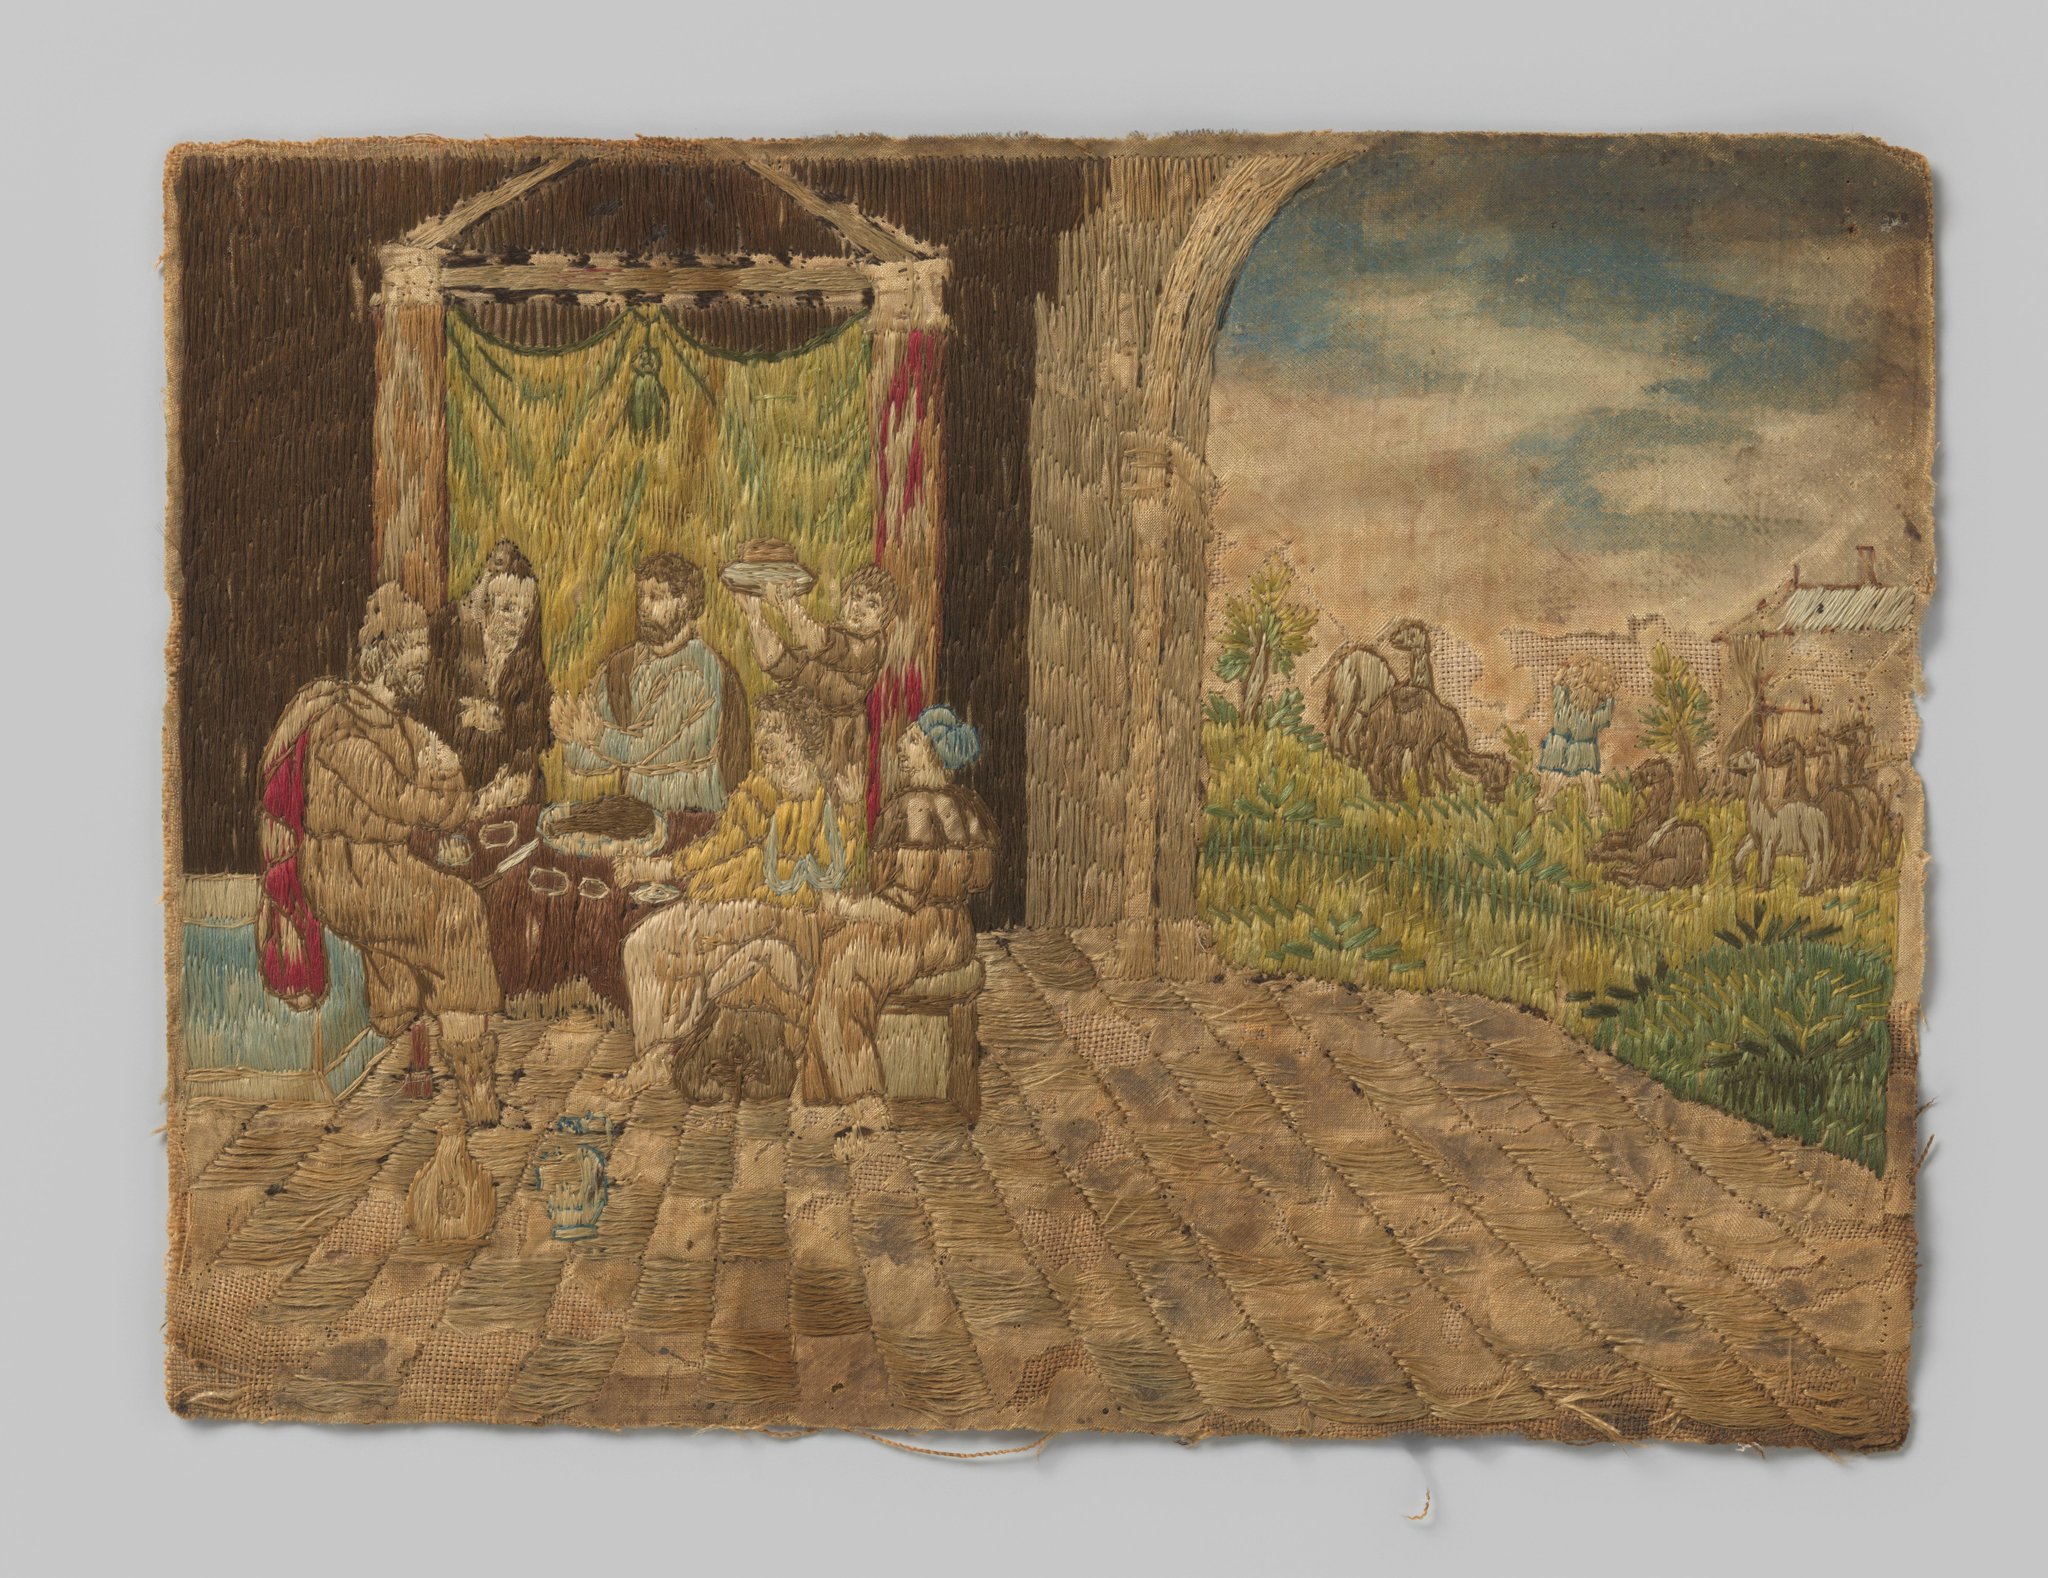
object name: tableau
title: Geborduurd tableau op zijde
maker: Anonymous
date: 1500-1700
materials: linen, silk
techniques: embroidered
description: Op zijde gewerkt tableau, voorstellende een maaltijd in een voorhuis.